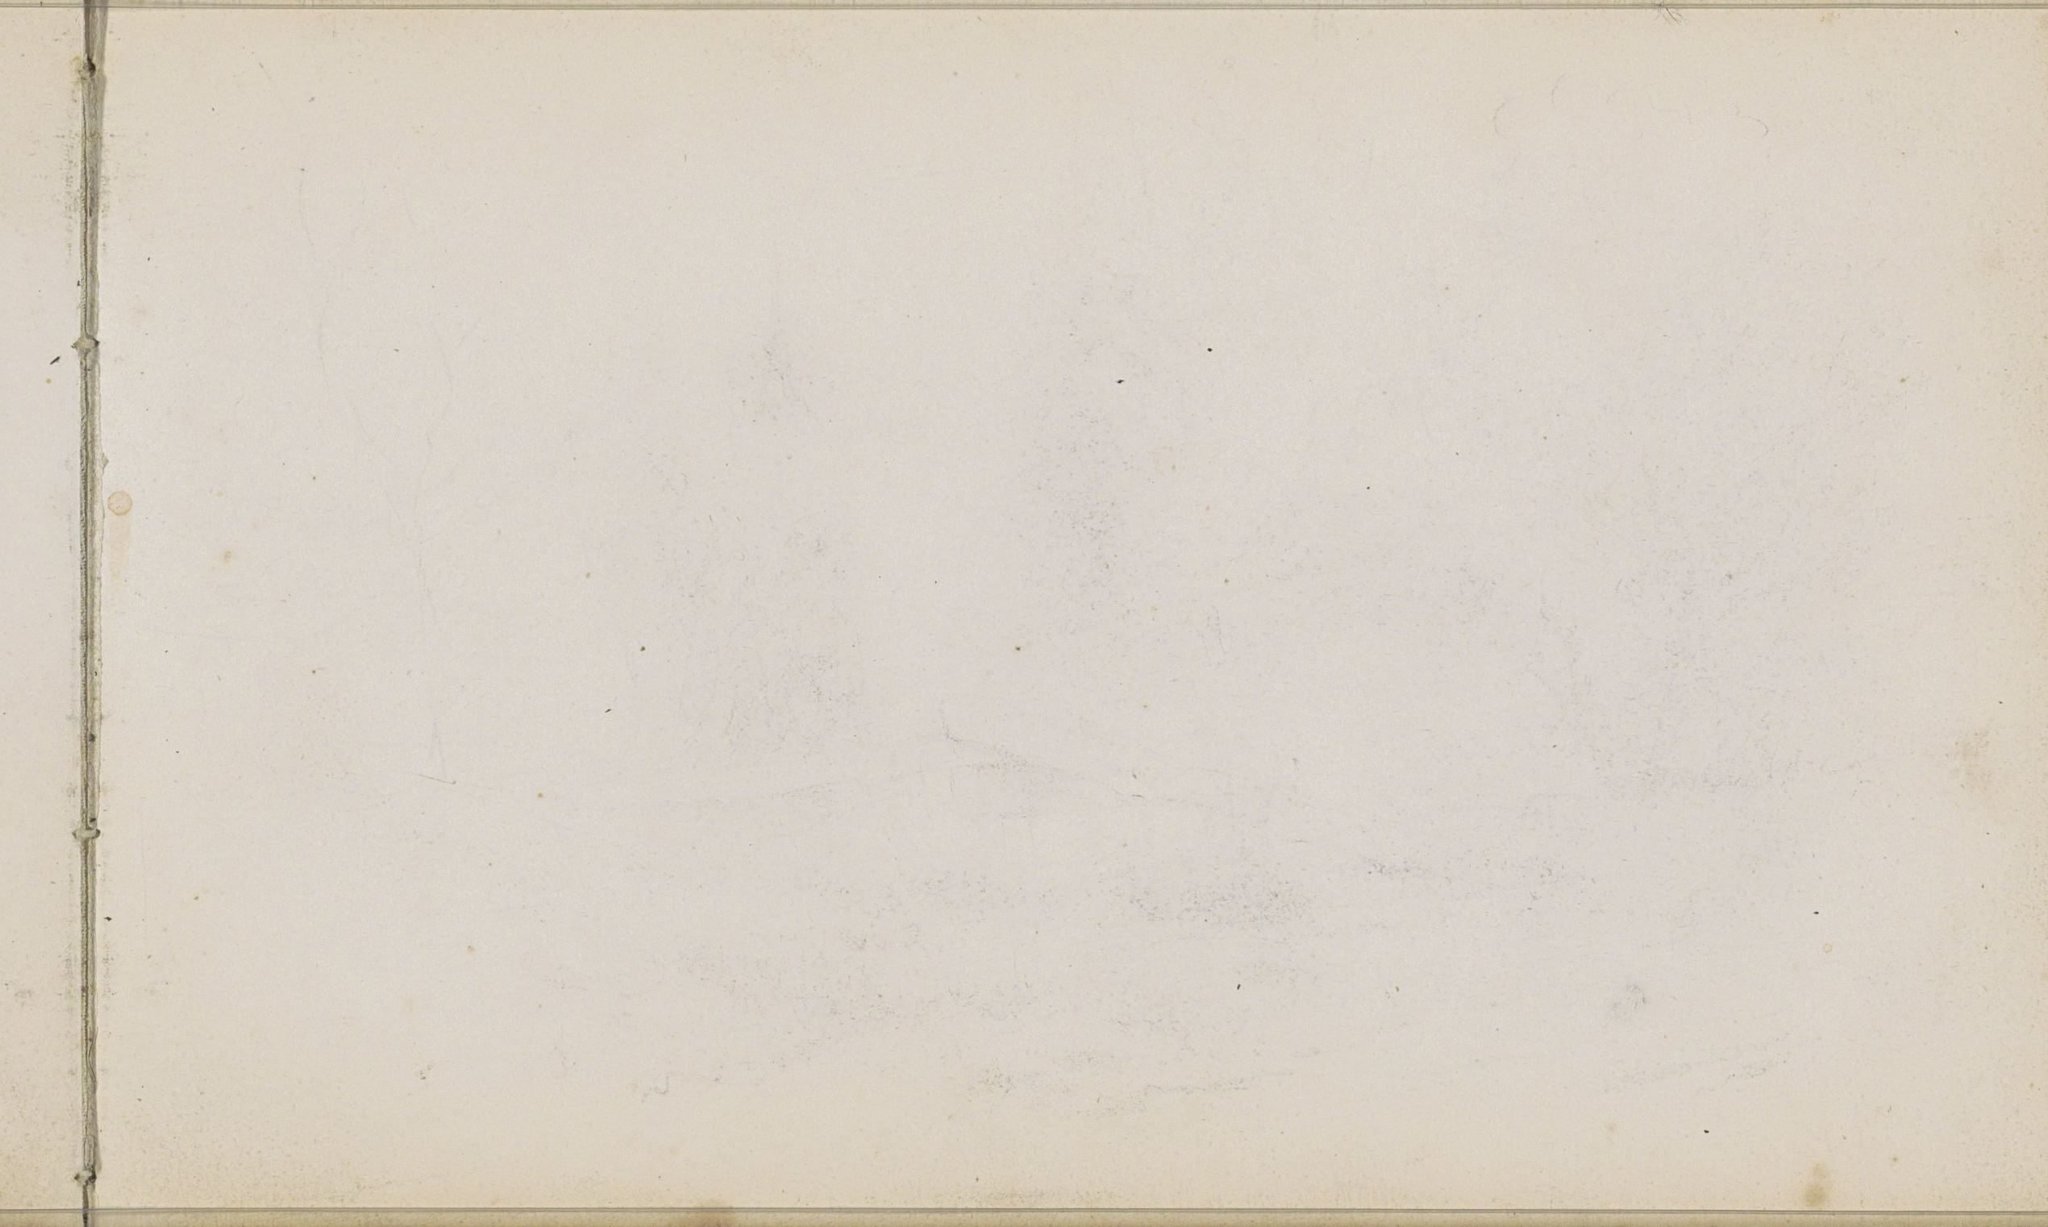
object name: sketchbook leaf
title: Studie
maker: willem cornelis rip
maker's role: draughtsman, painter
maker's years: 1856-1922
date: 1874-1875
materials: paper, pencil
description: Blad 23 recto uit een schetsboek met 46 bladen.